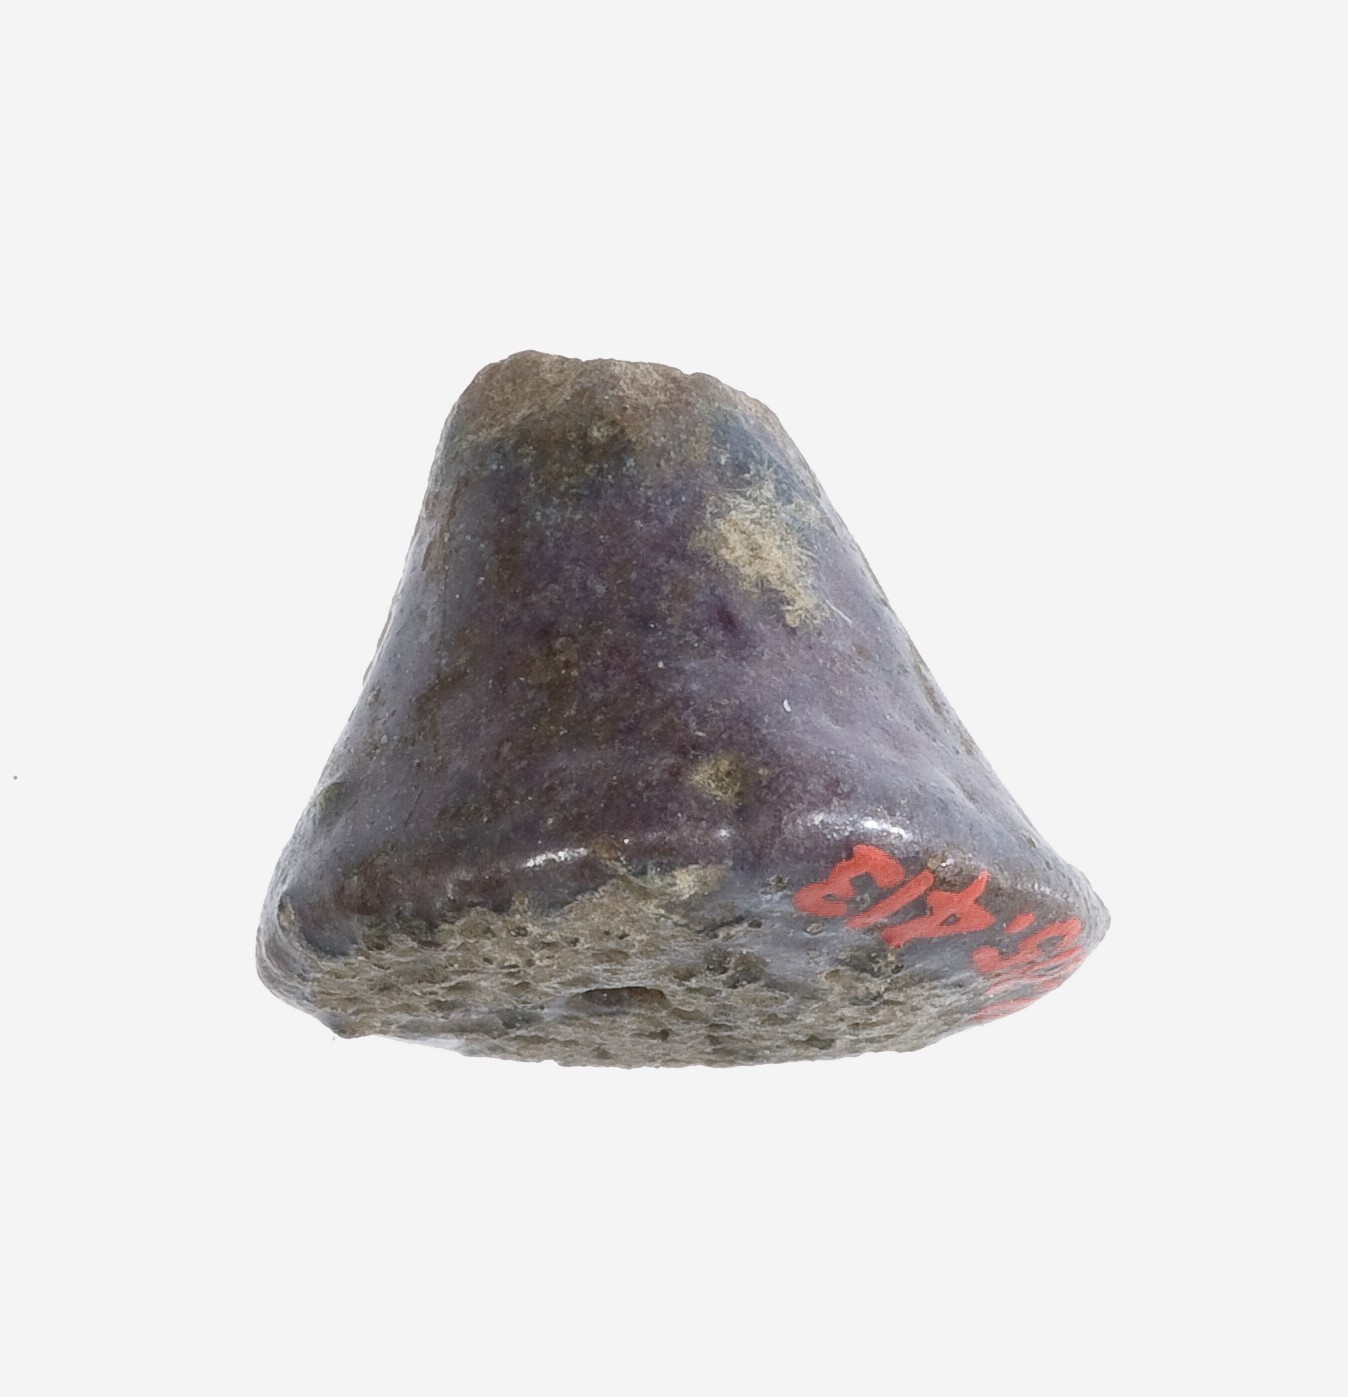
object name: pendant, umbel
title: Umbel Pendant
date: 1390-1352 BCE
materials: faience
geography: egypt